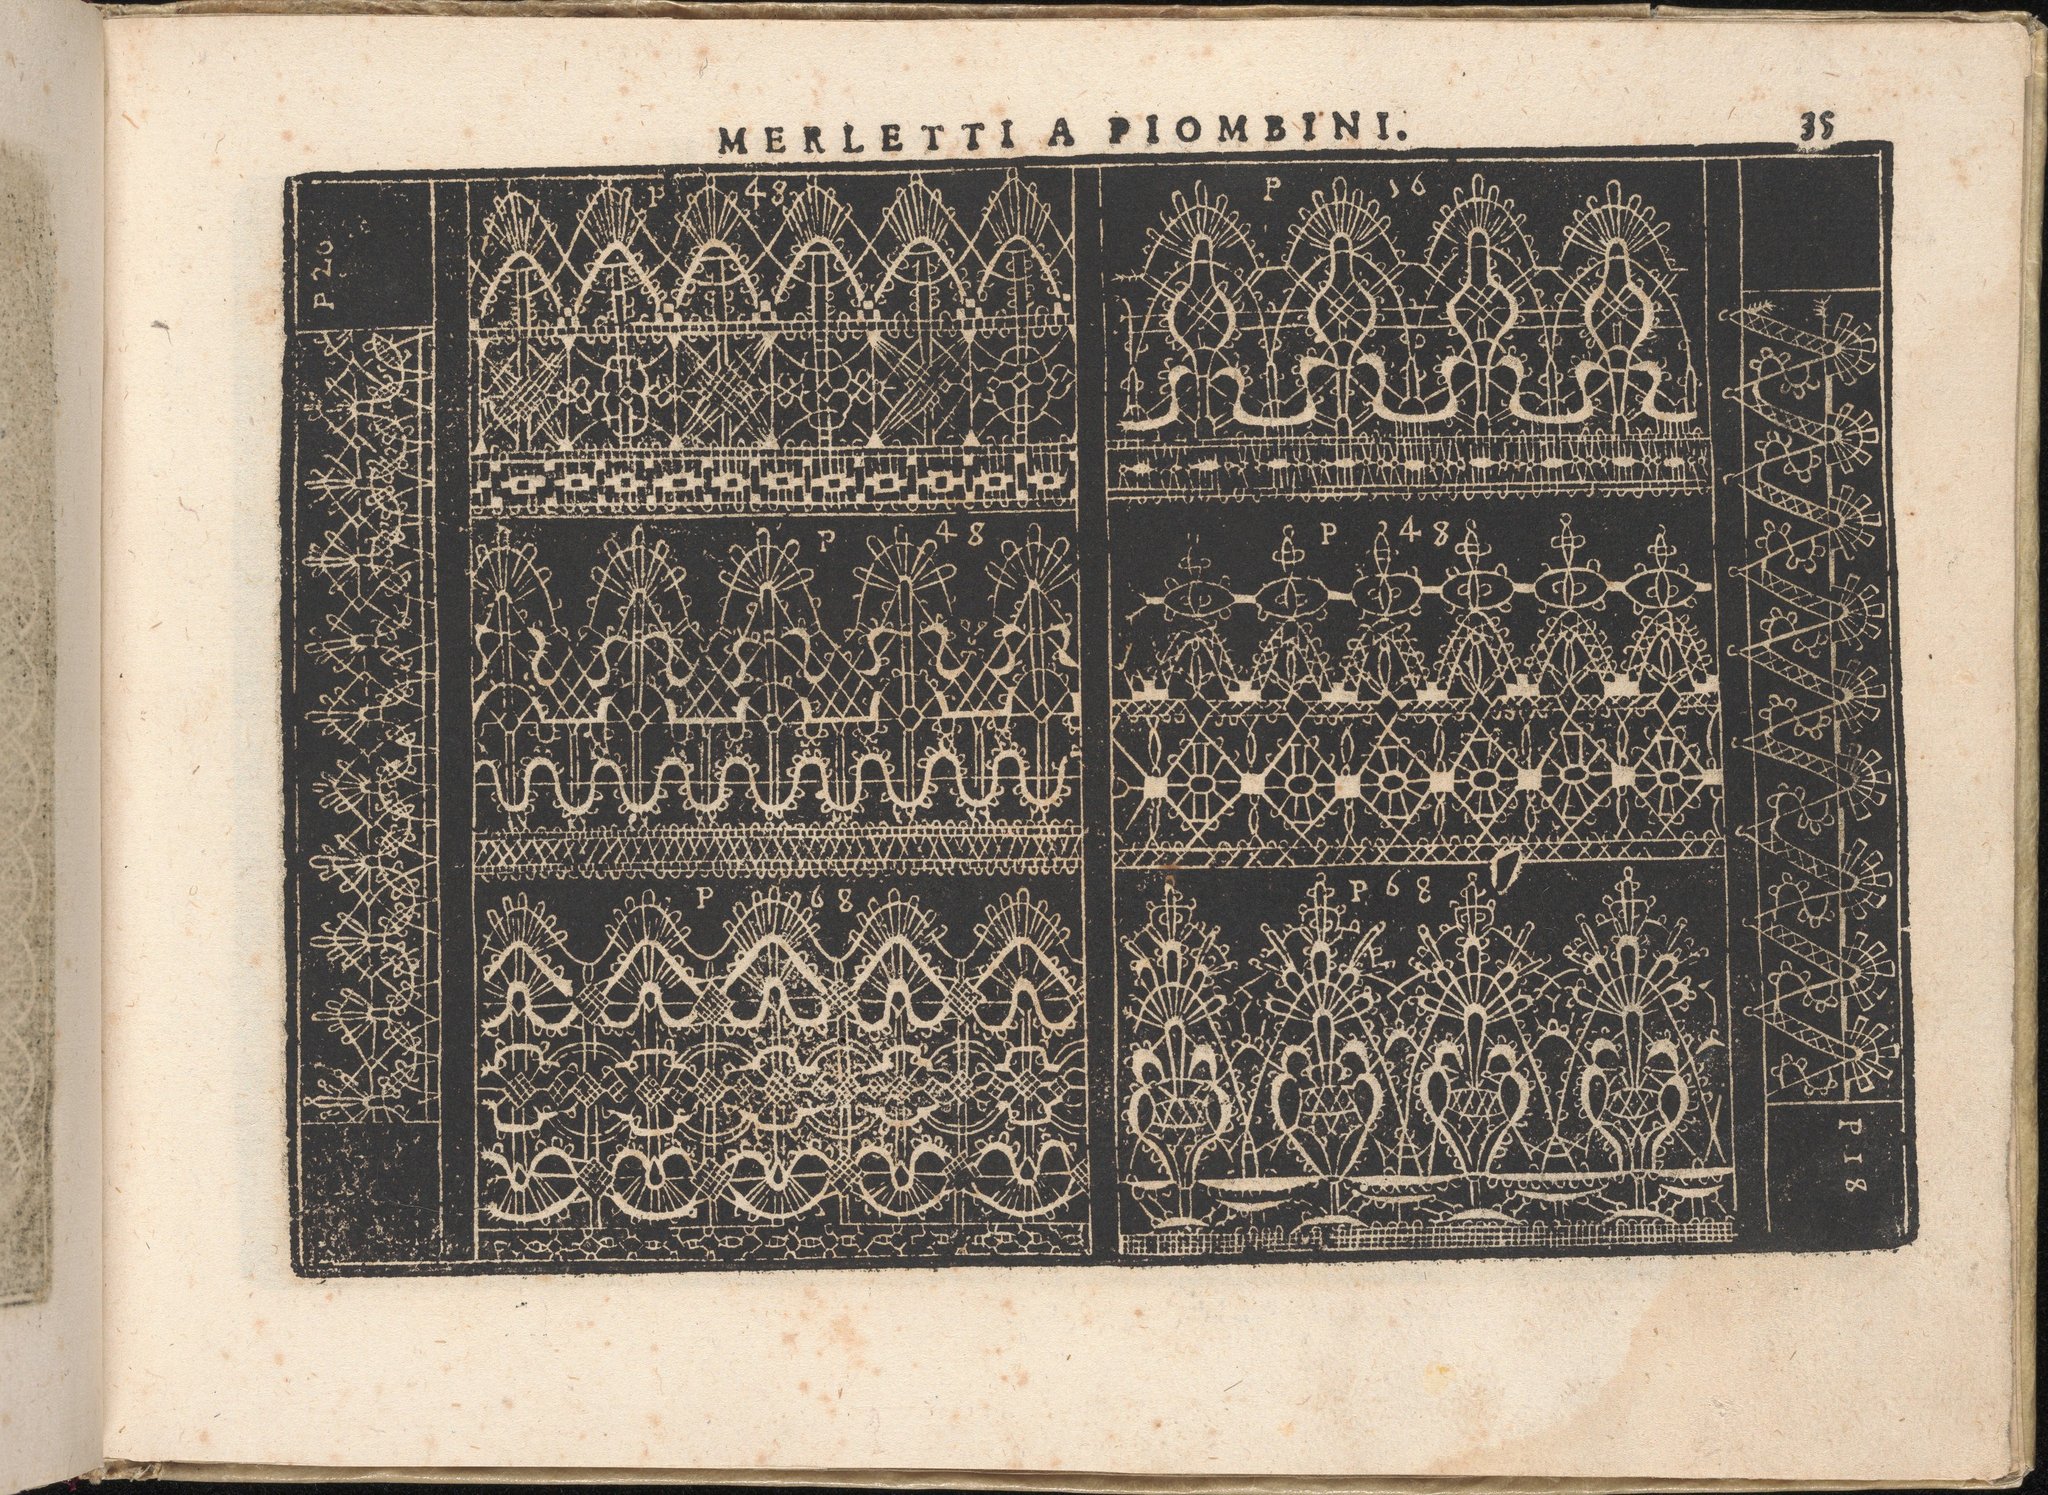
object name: book print ornament architecture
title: Fiore D'Ogni Virtu Per le Nobili Et Honeste Matrone, page 35 (recto)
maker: isabella catanea parasole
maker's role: designer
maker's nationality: italian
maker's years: 1565-1625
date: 1610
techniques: woodcut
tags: ornament